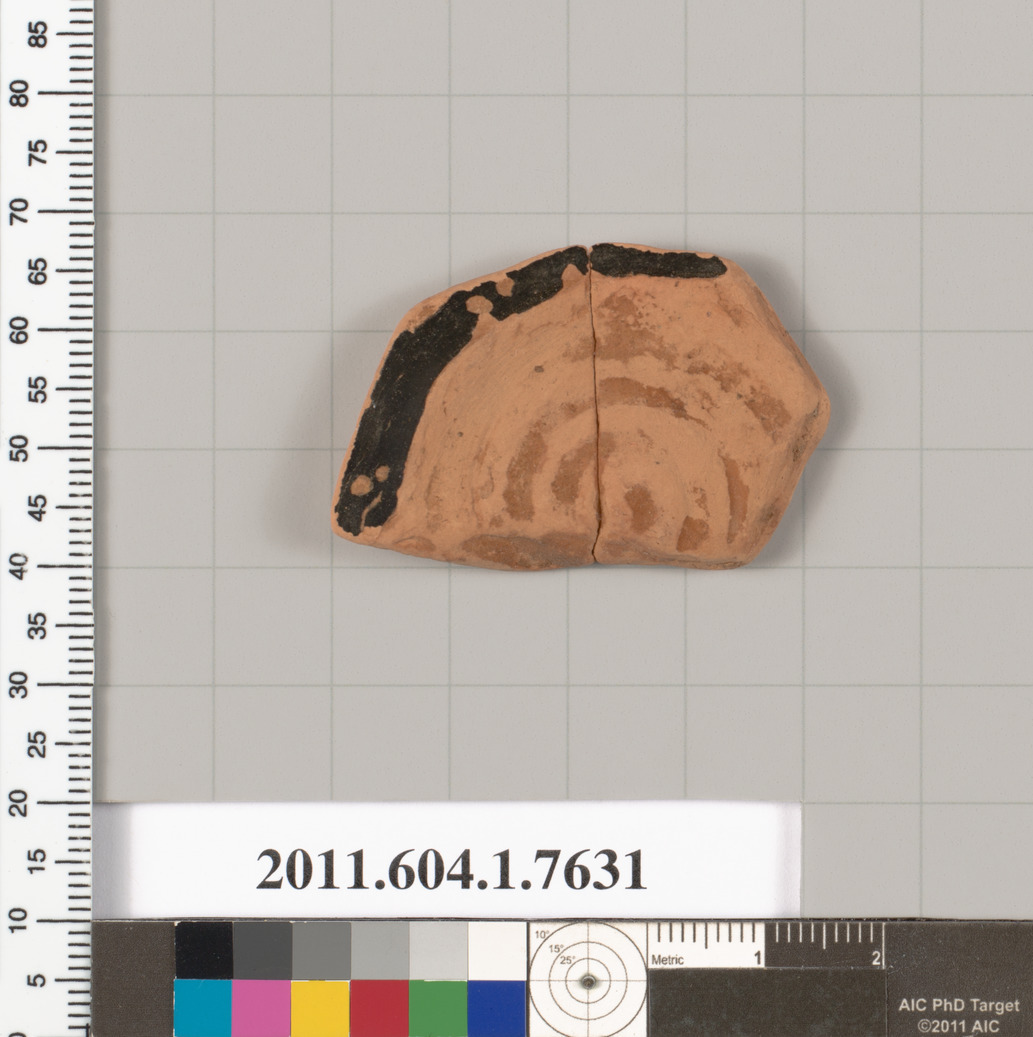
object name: kylix fragment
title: Terracotta fragment of a kylix (drinking cup)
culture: greek, attic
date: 460-450 BCE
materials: terracotta